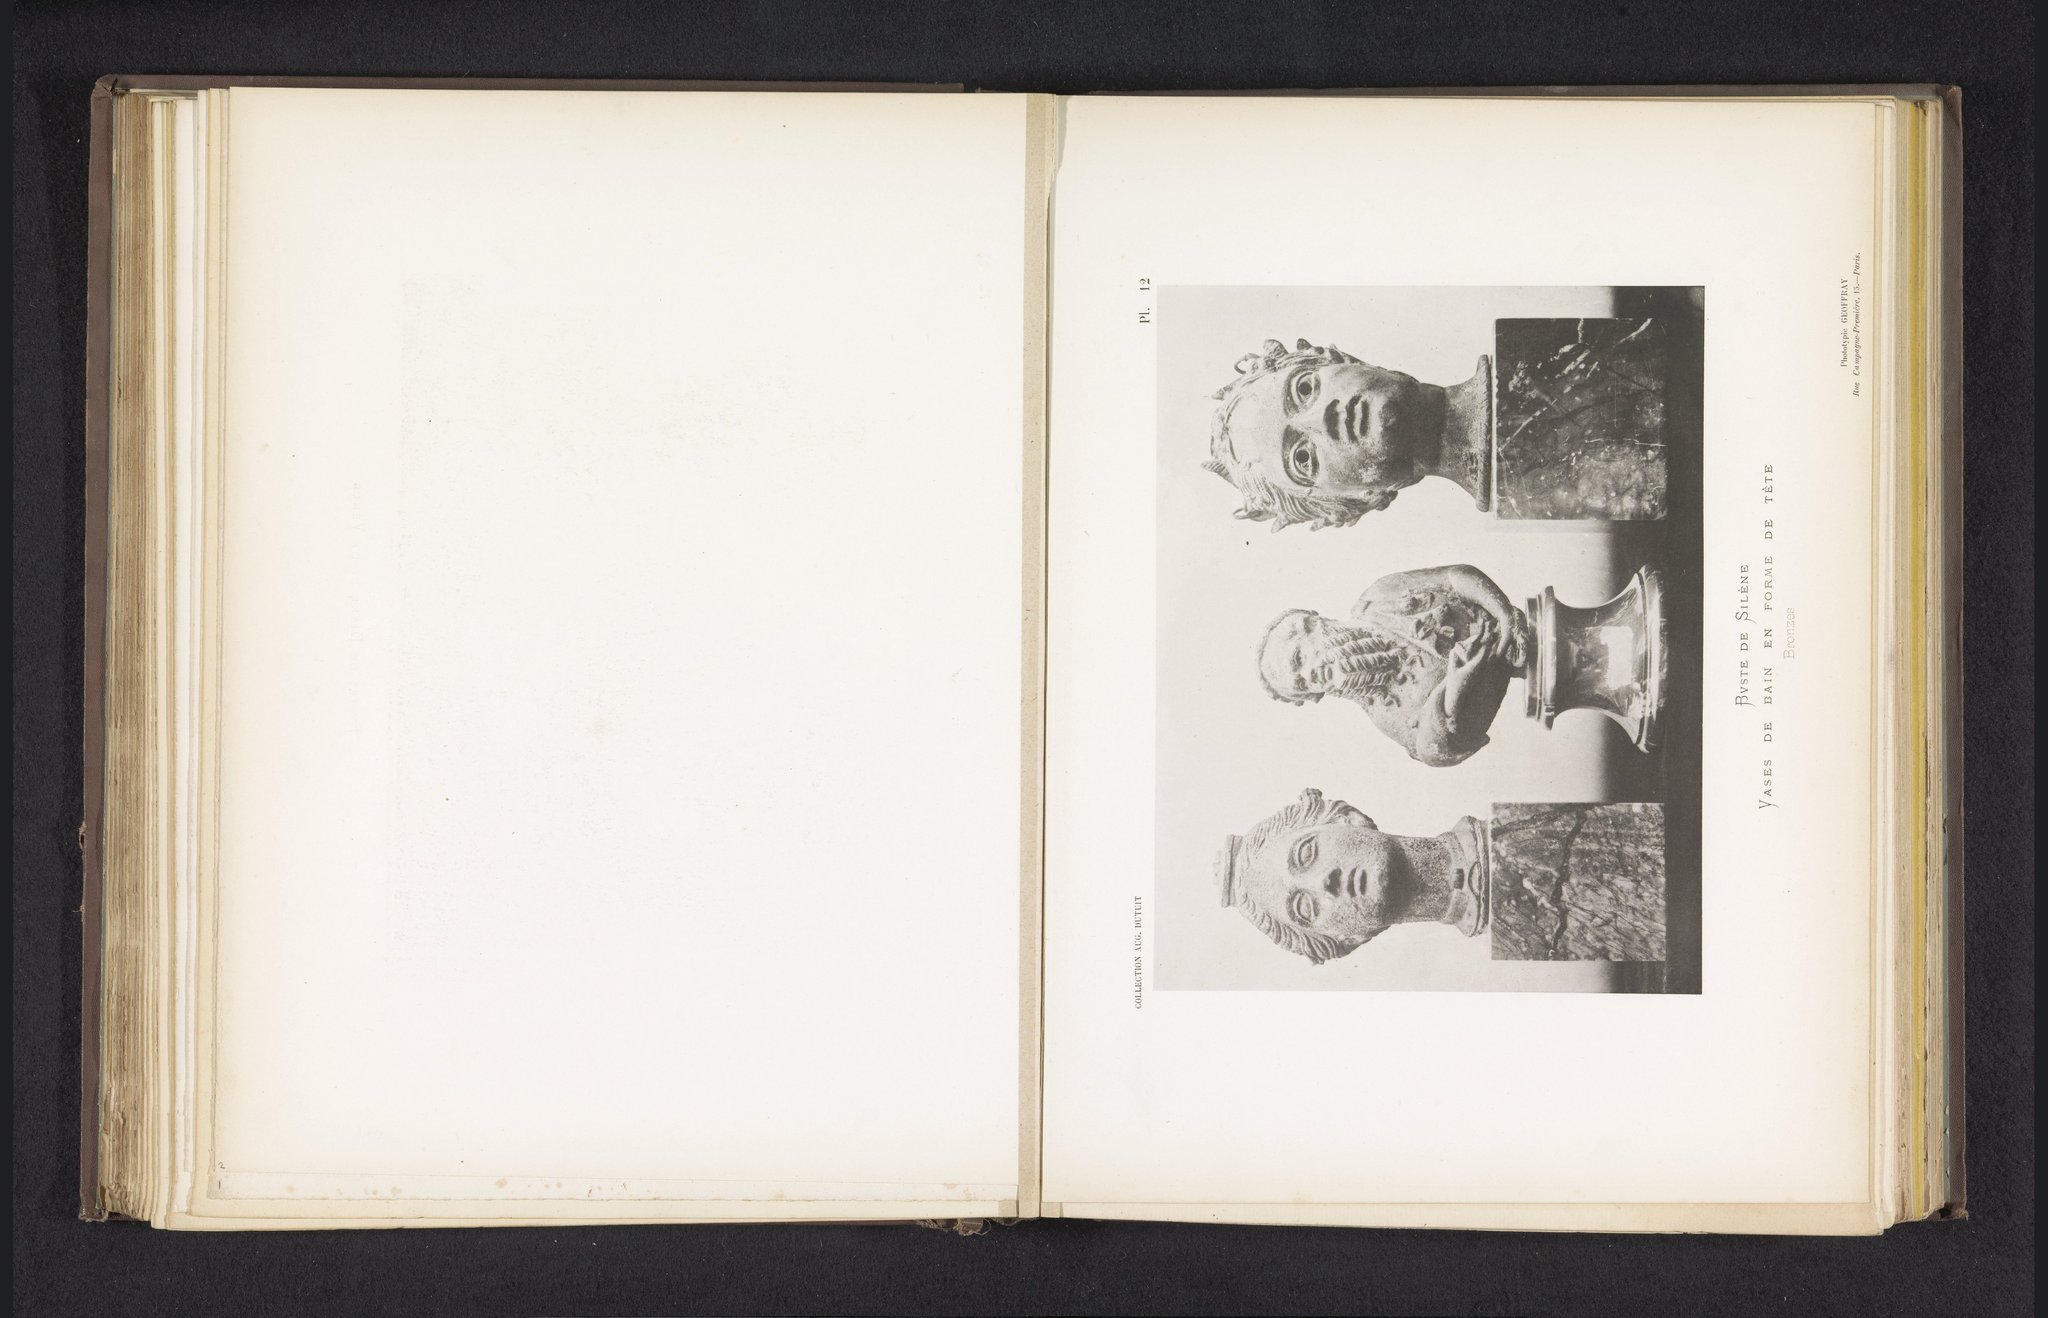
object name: photomechanical print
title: Buste de Silène Vases de bain en forme de tête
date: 1879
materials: paper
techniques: photograph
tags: piece of sculpture, reproduction of a piece of sculpture, container of metal: bucket, can, canister, drum, tin, chest, bust - aa - female human figure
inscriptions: number: ‘Pl. 12’